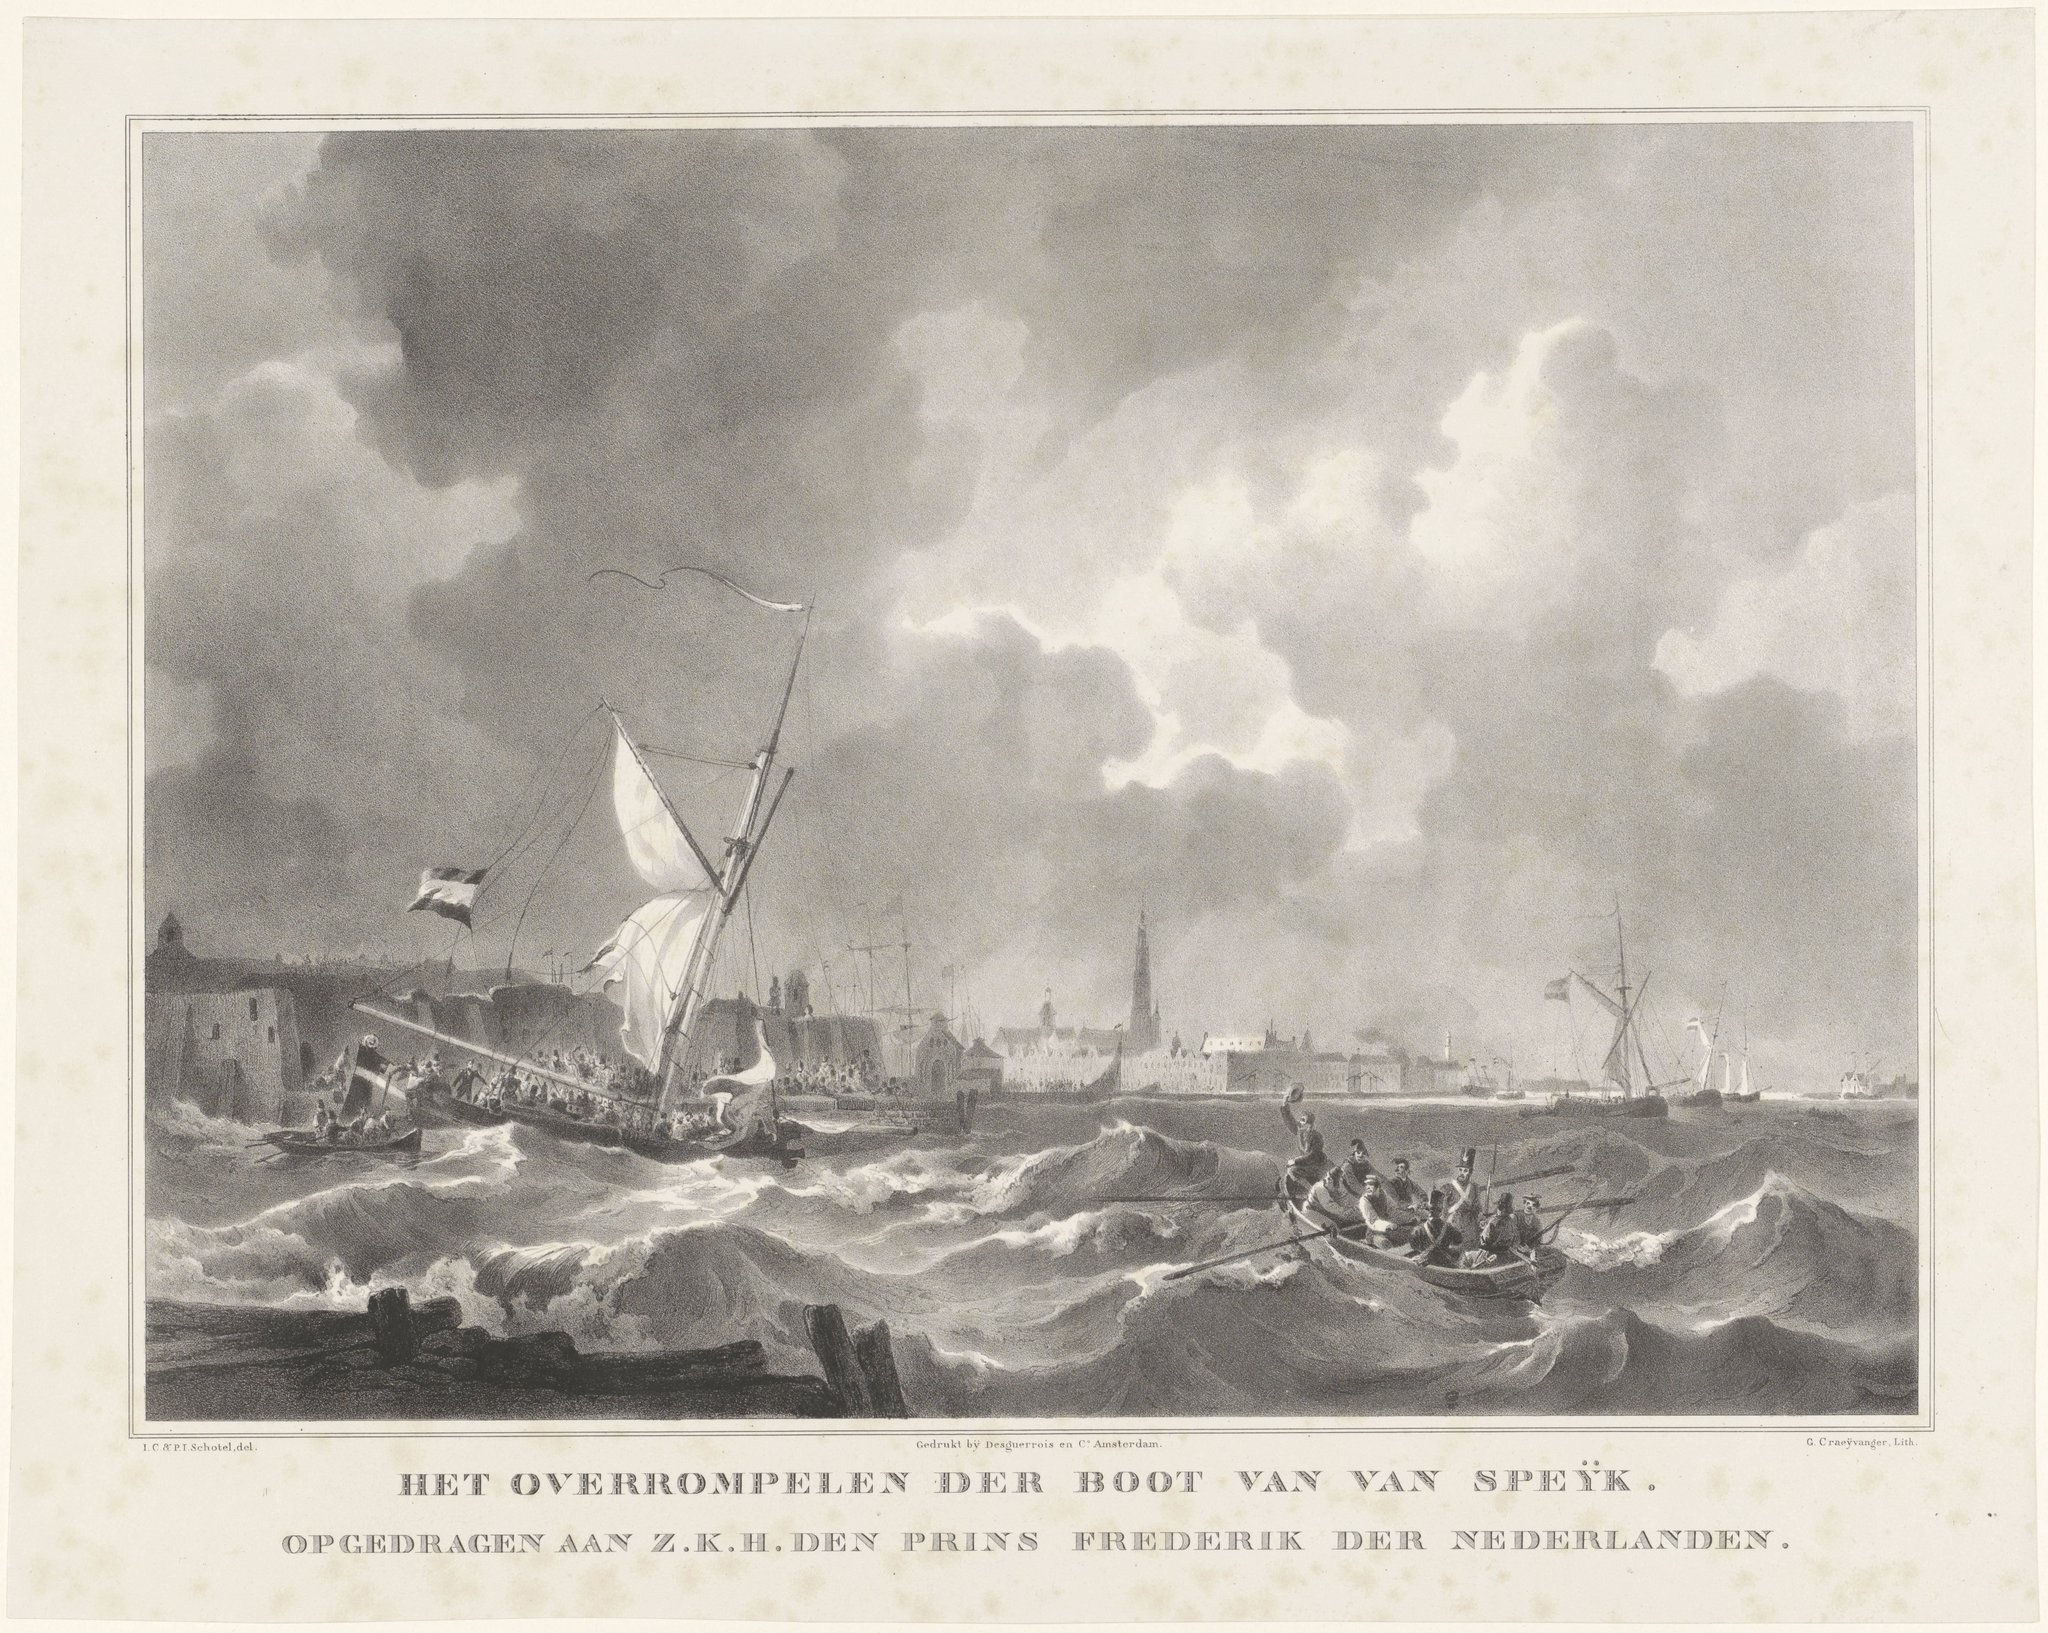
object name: print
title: Het Overrompelen der boot van van Speijk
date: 1831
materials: paper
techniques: lithograph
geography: netherlands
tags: amsterdam, antwerp, jan van speyk, navy (+ sailing-ships)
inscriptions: collector's mark: Lugt 2228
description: Gezicht op de Schelde met links de kanonneerboot van Jan van Speyk overrompeld door de Belgen, 5 februari 1831. Op de voorgrond een sloep die richting de kanonneerboot wordt geroeid. Van Speyk staat op het dek. Zie ook de pendant.